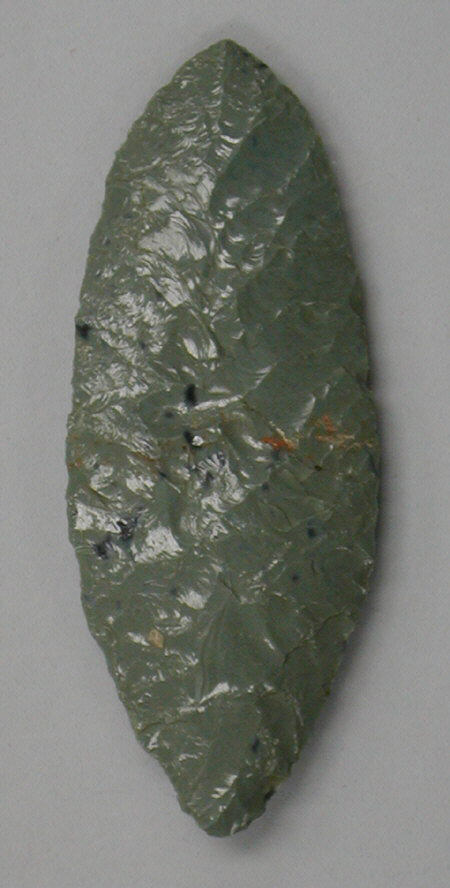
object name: knife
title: Obsidian Blade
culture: mexican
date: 1501-1600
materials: obsidian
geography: mexico